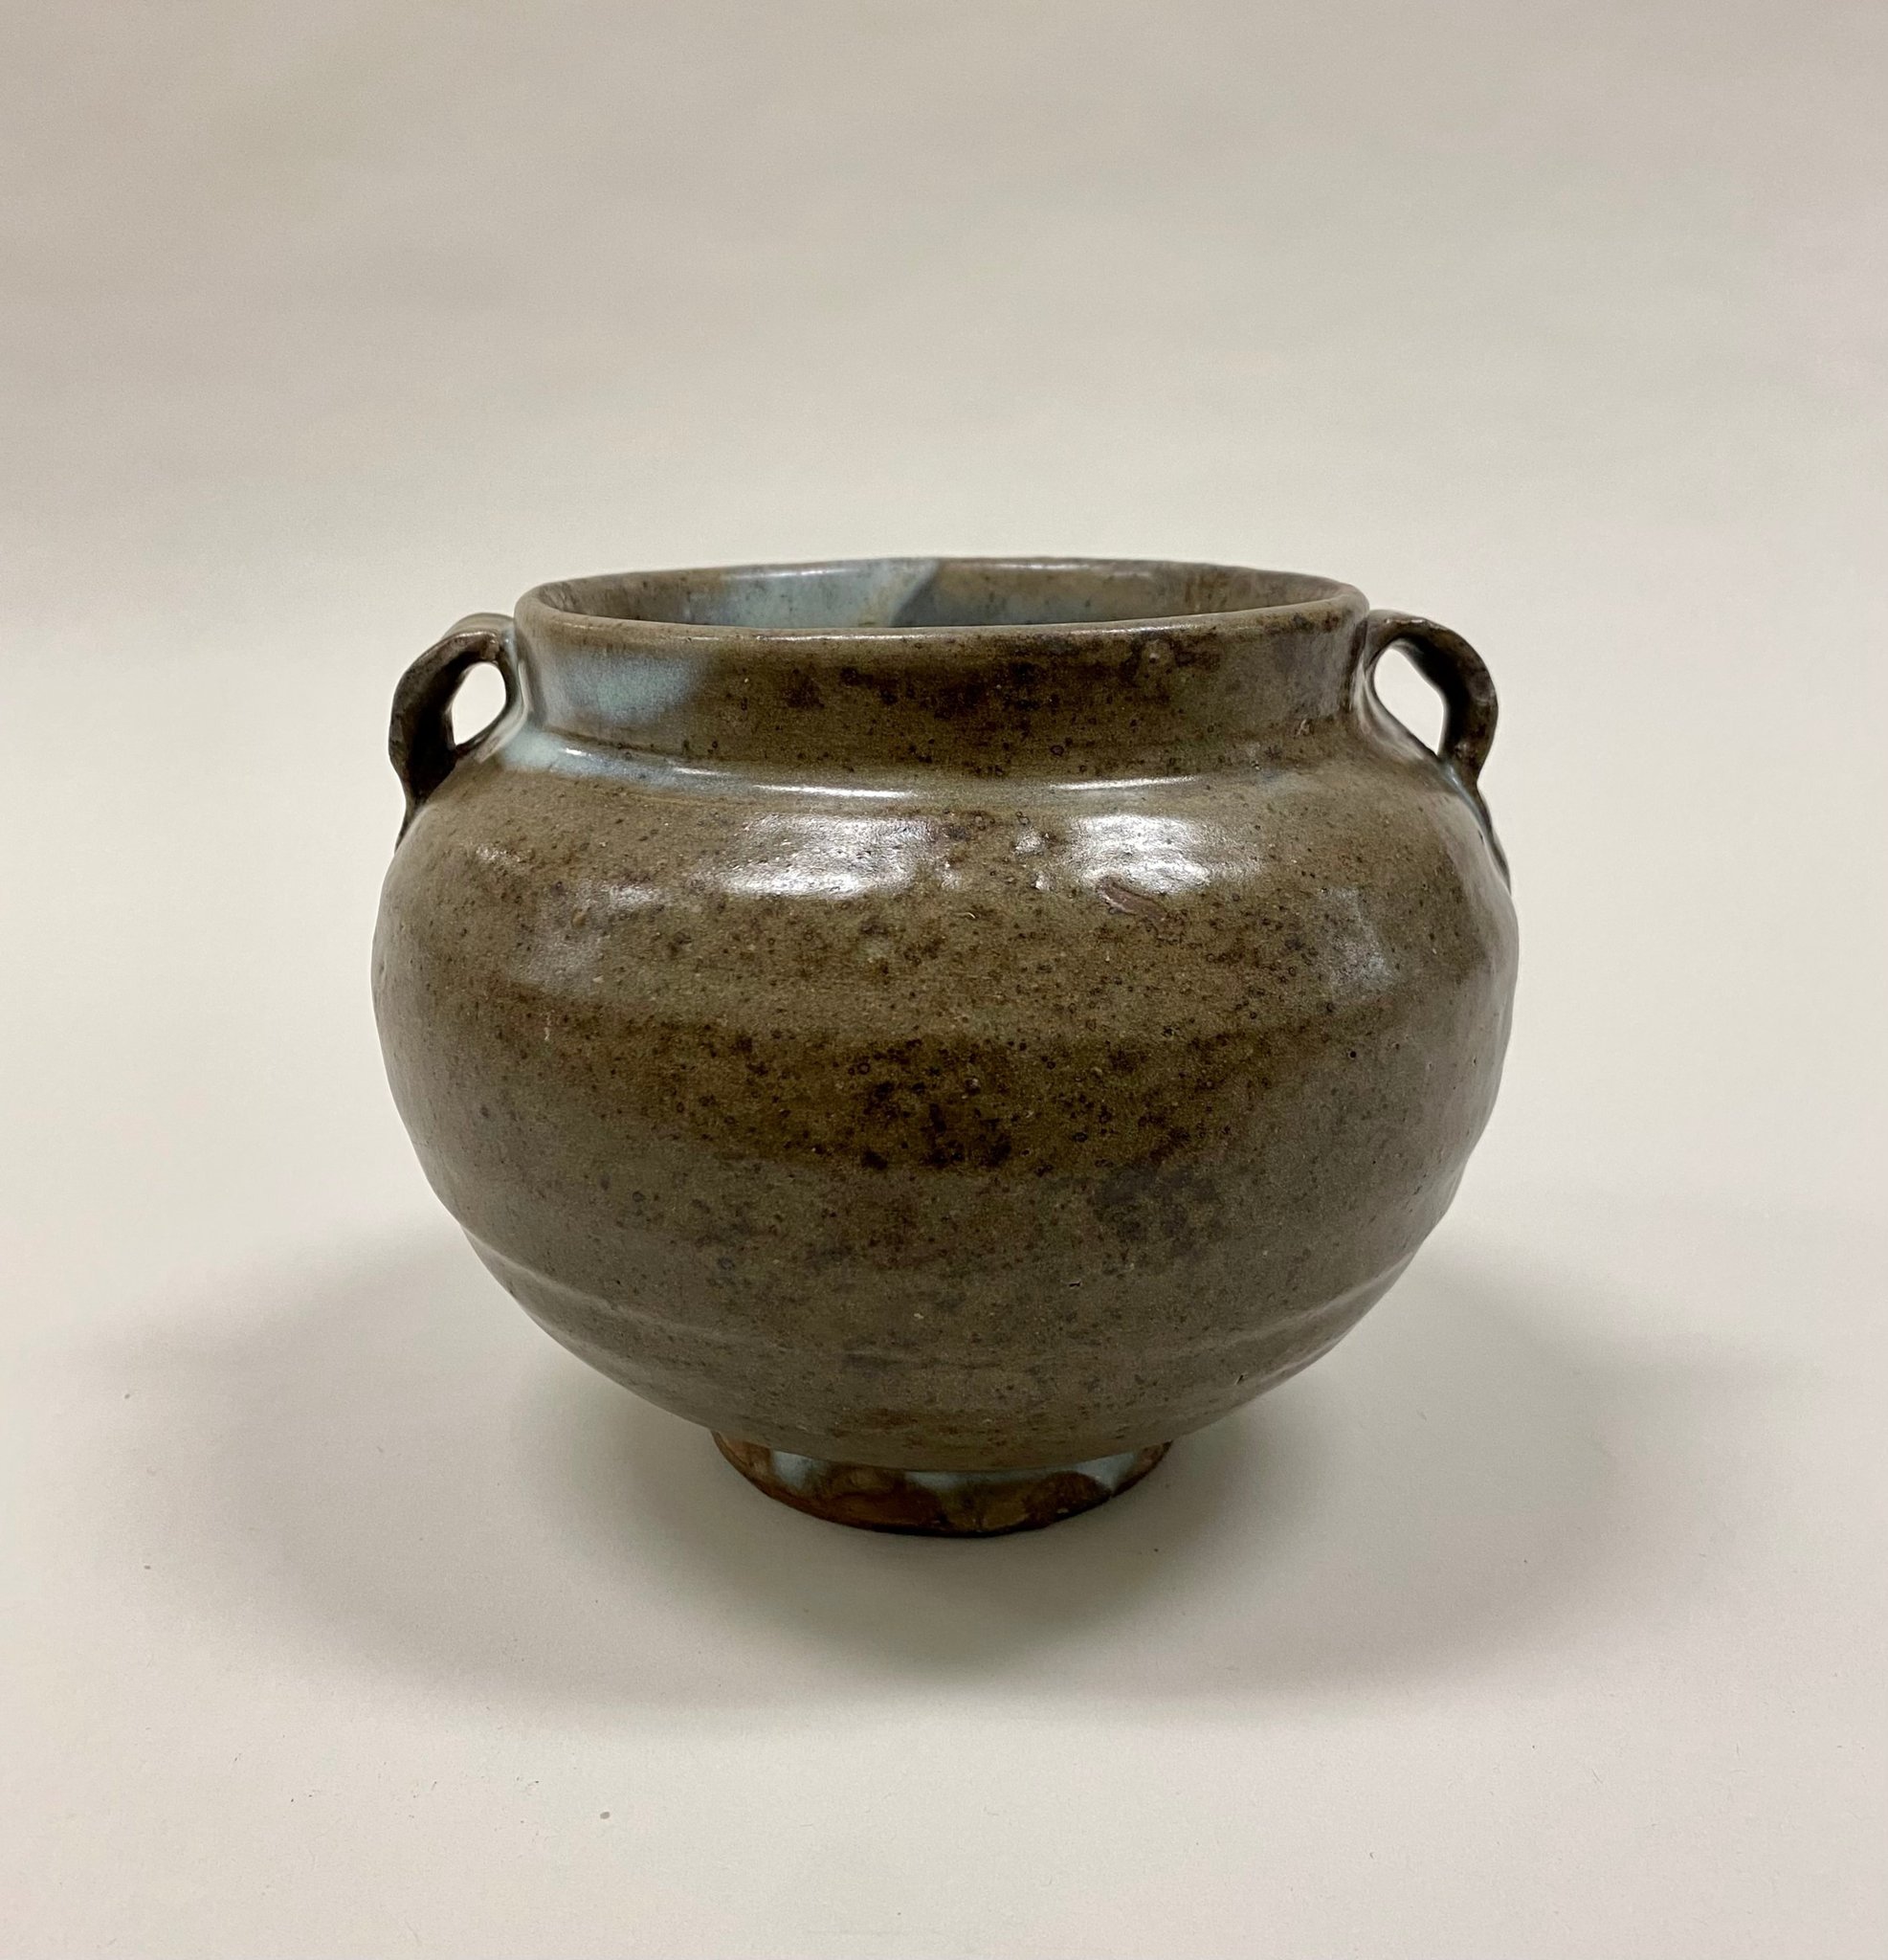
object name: jar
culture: chinese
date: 1201-1400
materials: glaze, stoneware